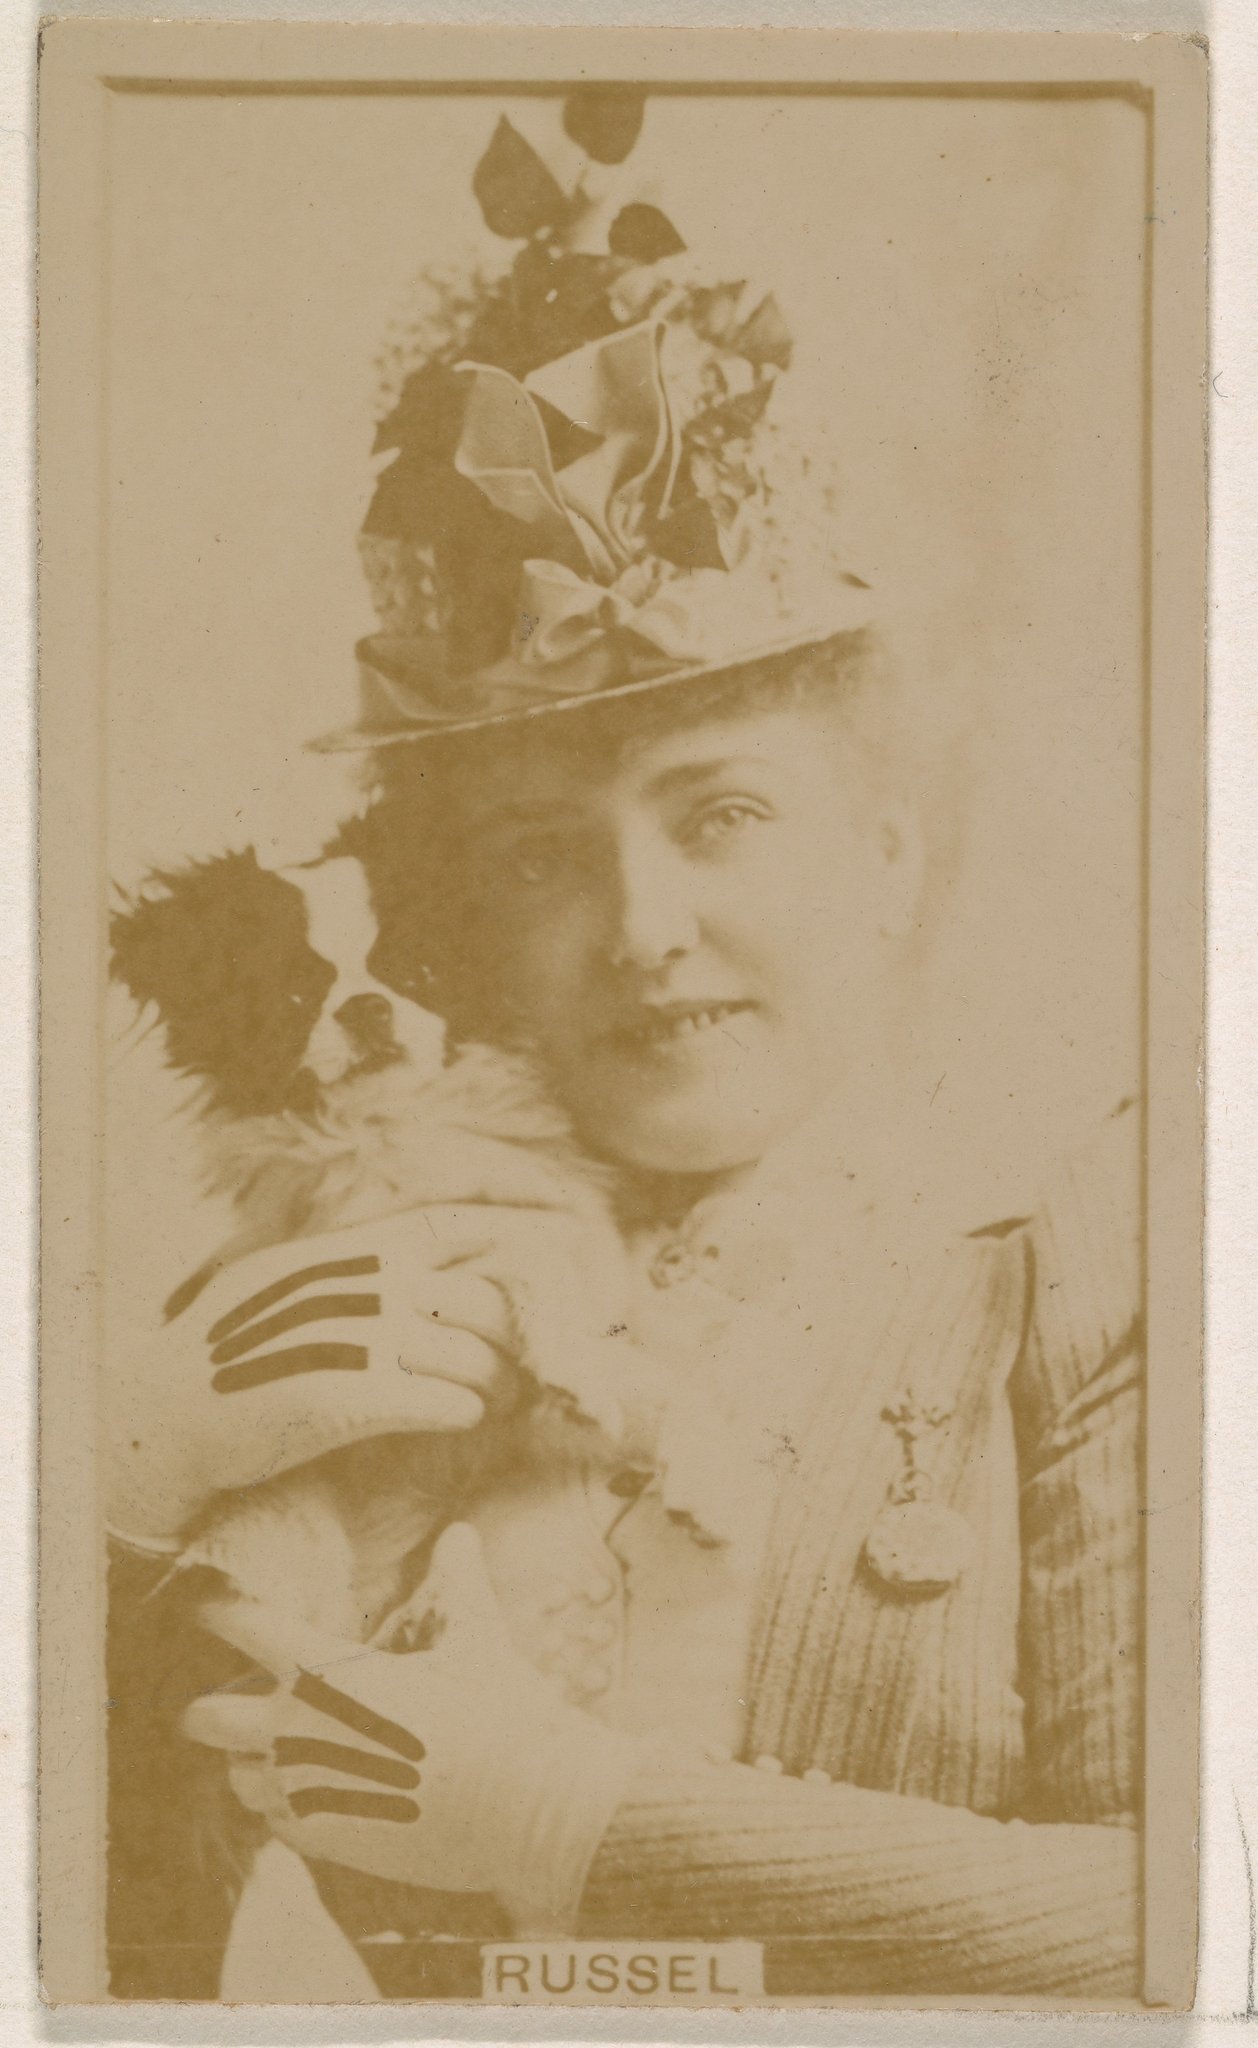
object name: photograph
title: Miss Russel, from the Actresses series (N245) issued by Kinney Brothers to promote Sweet Caporal Cigarettes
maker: kinney brothers tobacco company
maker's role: publisher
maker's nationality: american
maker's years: 1869-2011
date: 1890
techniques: albumen silver print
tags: portraits,women,actresses